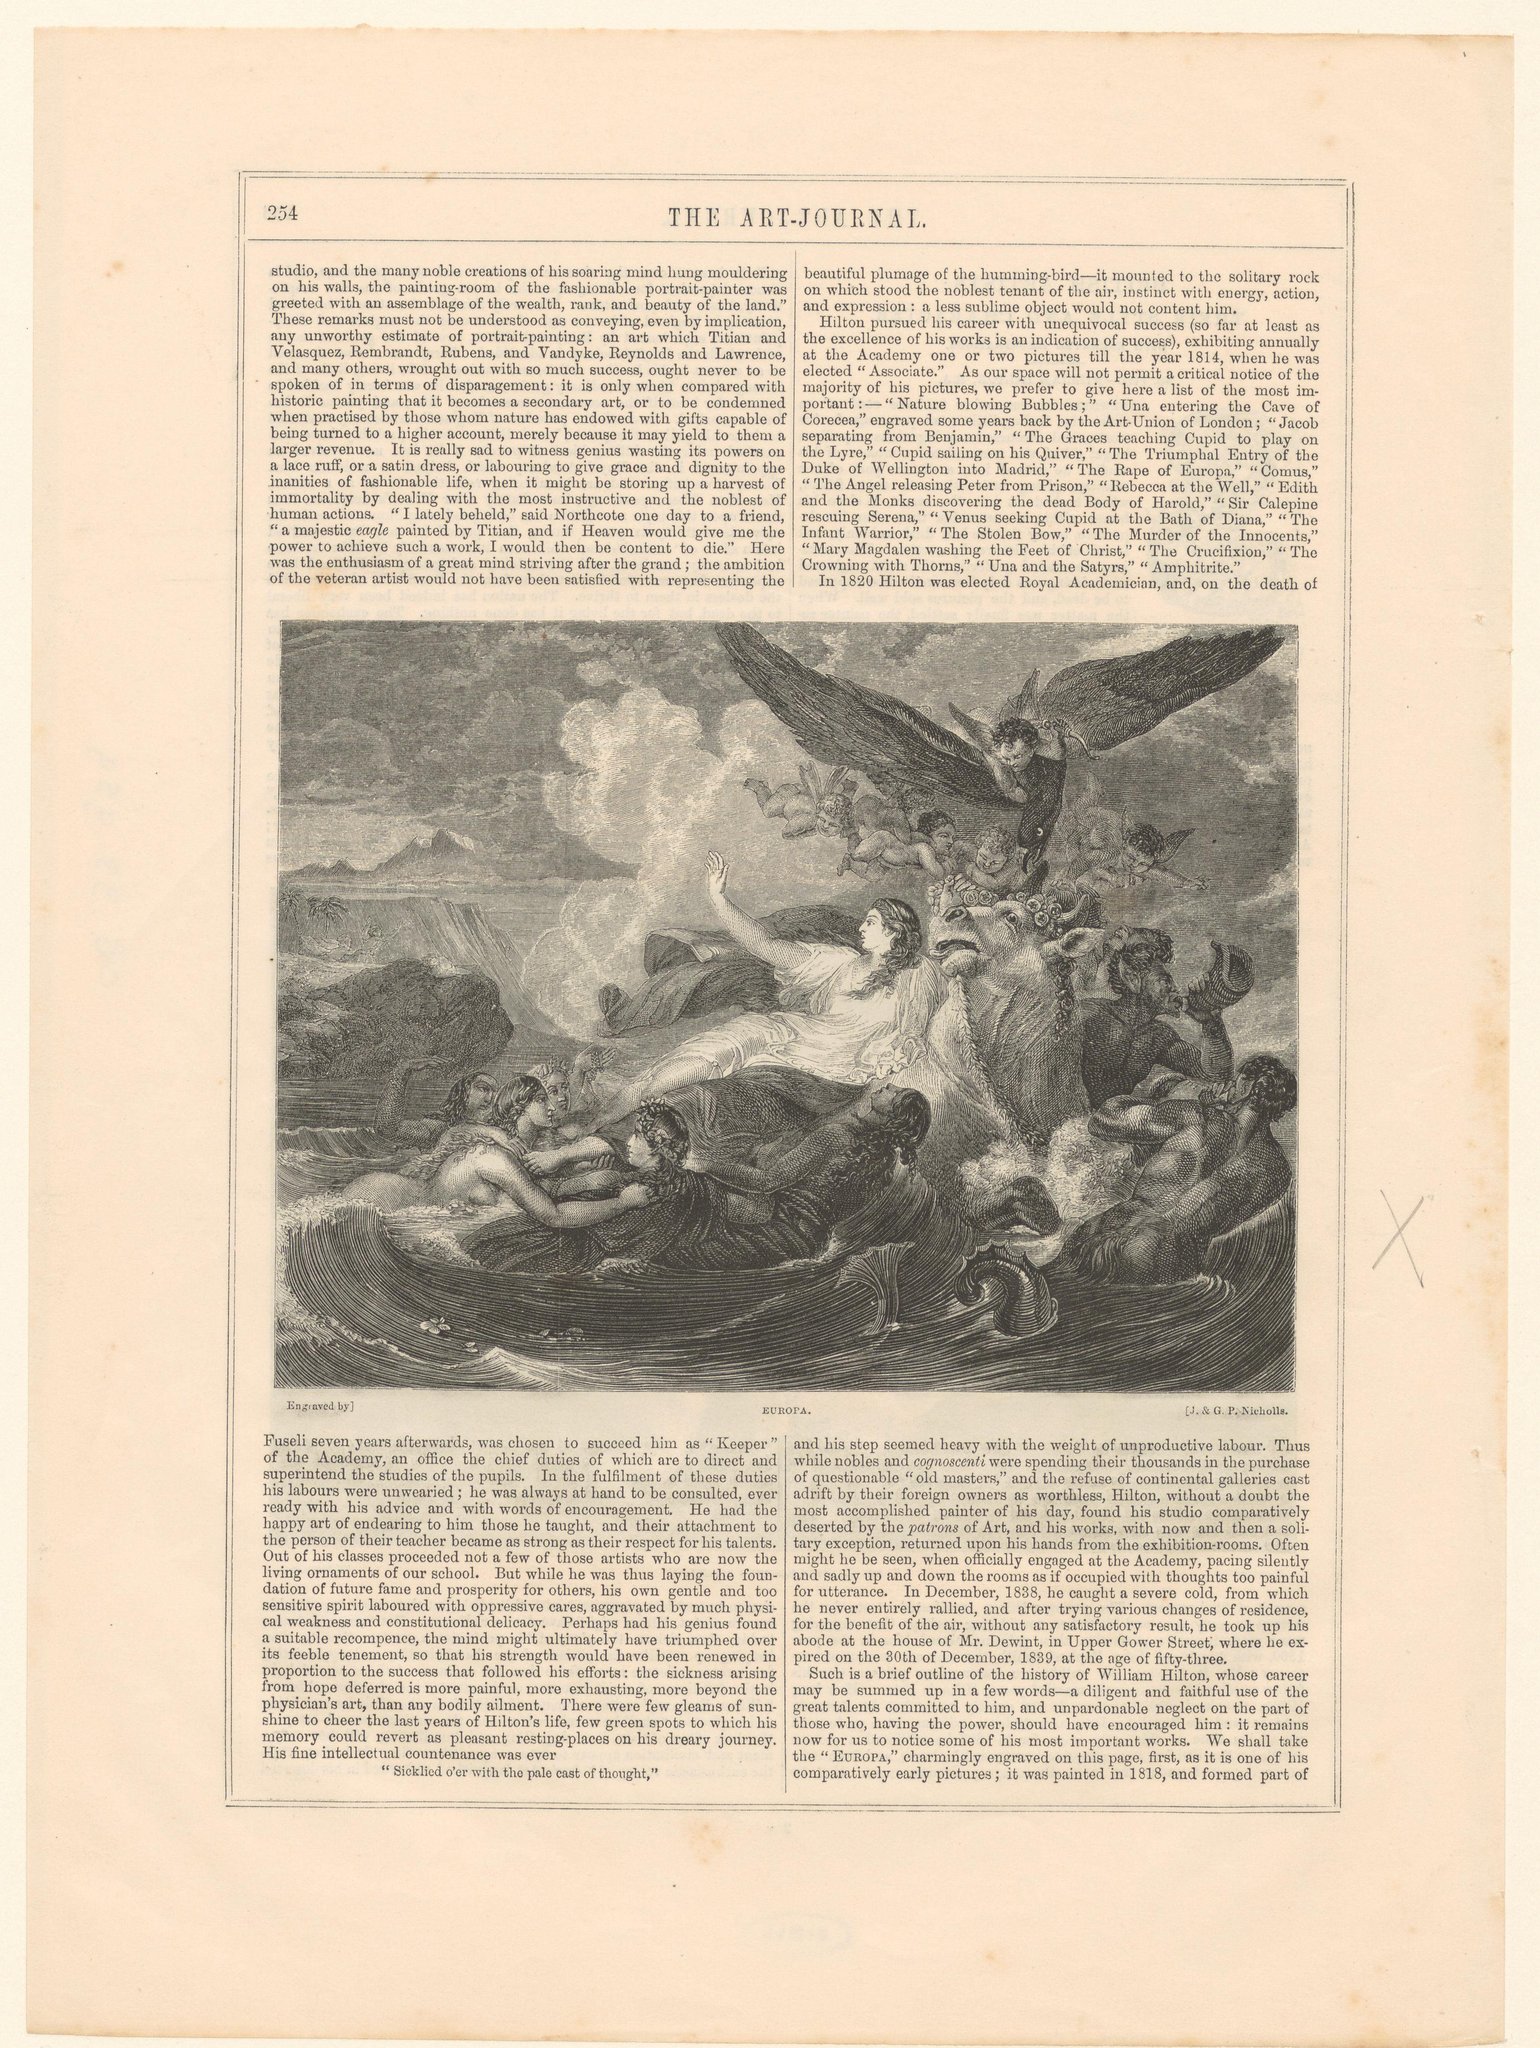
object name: print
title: Sir Calepine rescuing Serena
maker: thomas williams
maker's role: print maker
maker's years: 1800-1840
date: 1855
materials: paper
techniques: letterpress printing, engraving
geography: london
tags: jupiter, usually in the shape of a white bull, abducts europa and carries her across the water, being attacked; defence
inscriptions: collector's mark: Lugt 2228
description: Prent uit: The Art Journal (1855), 1855, p. 253.